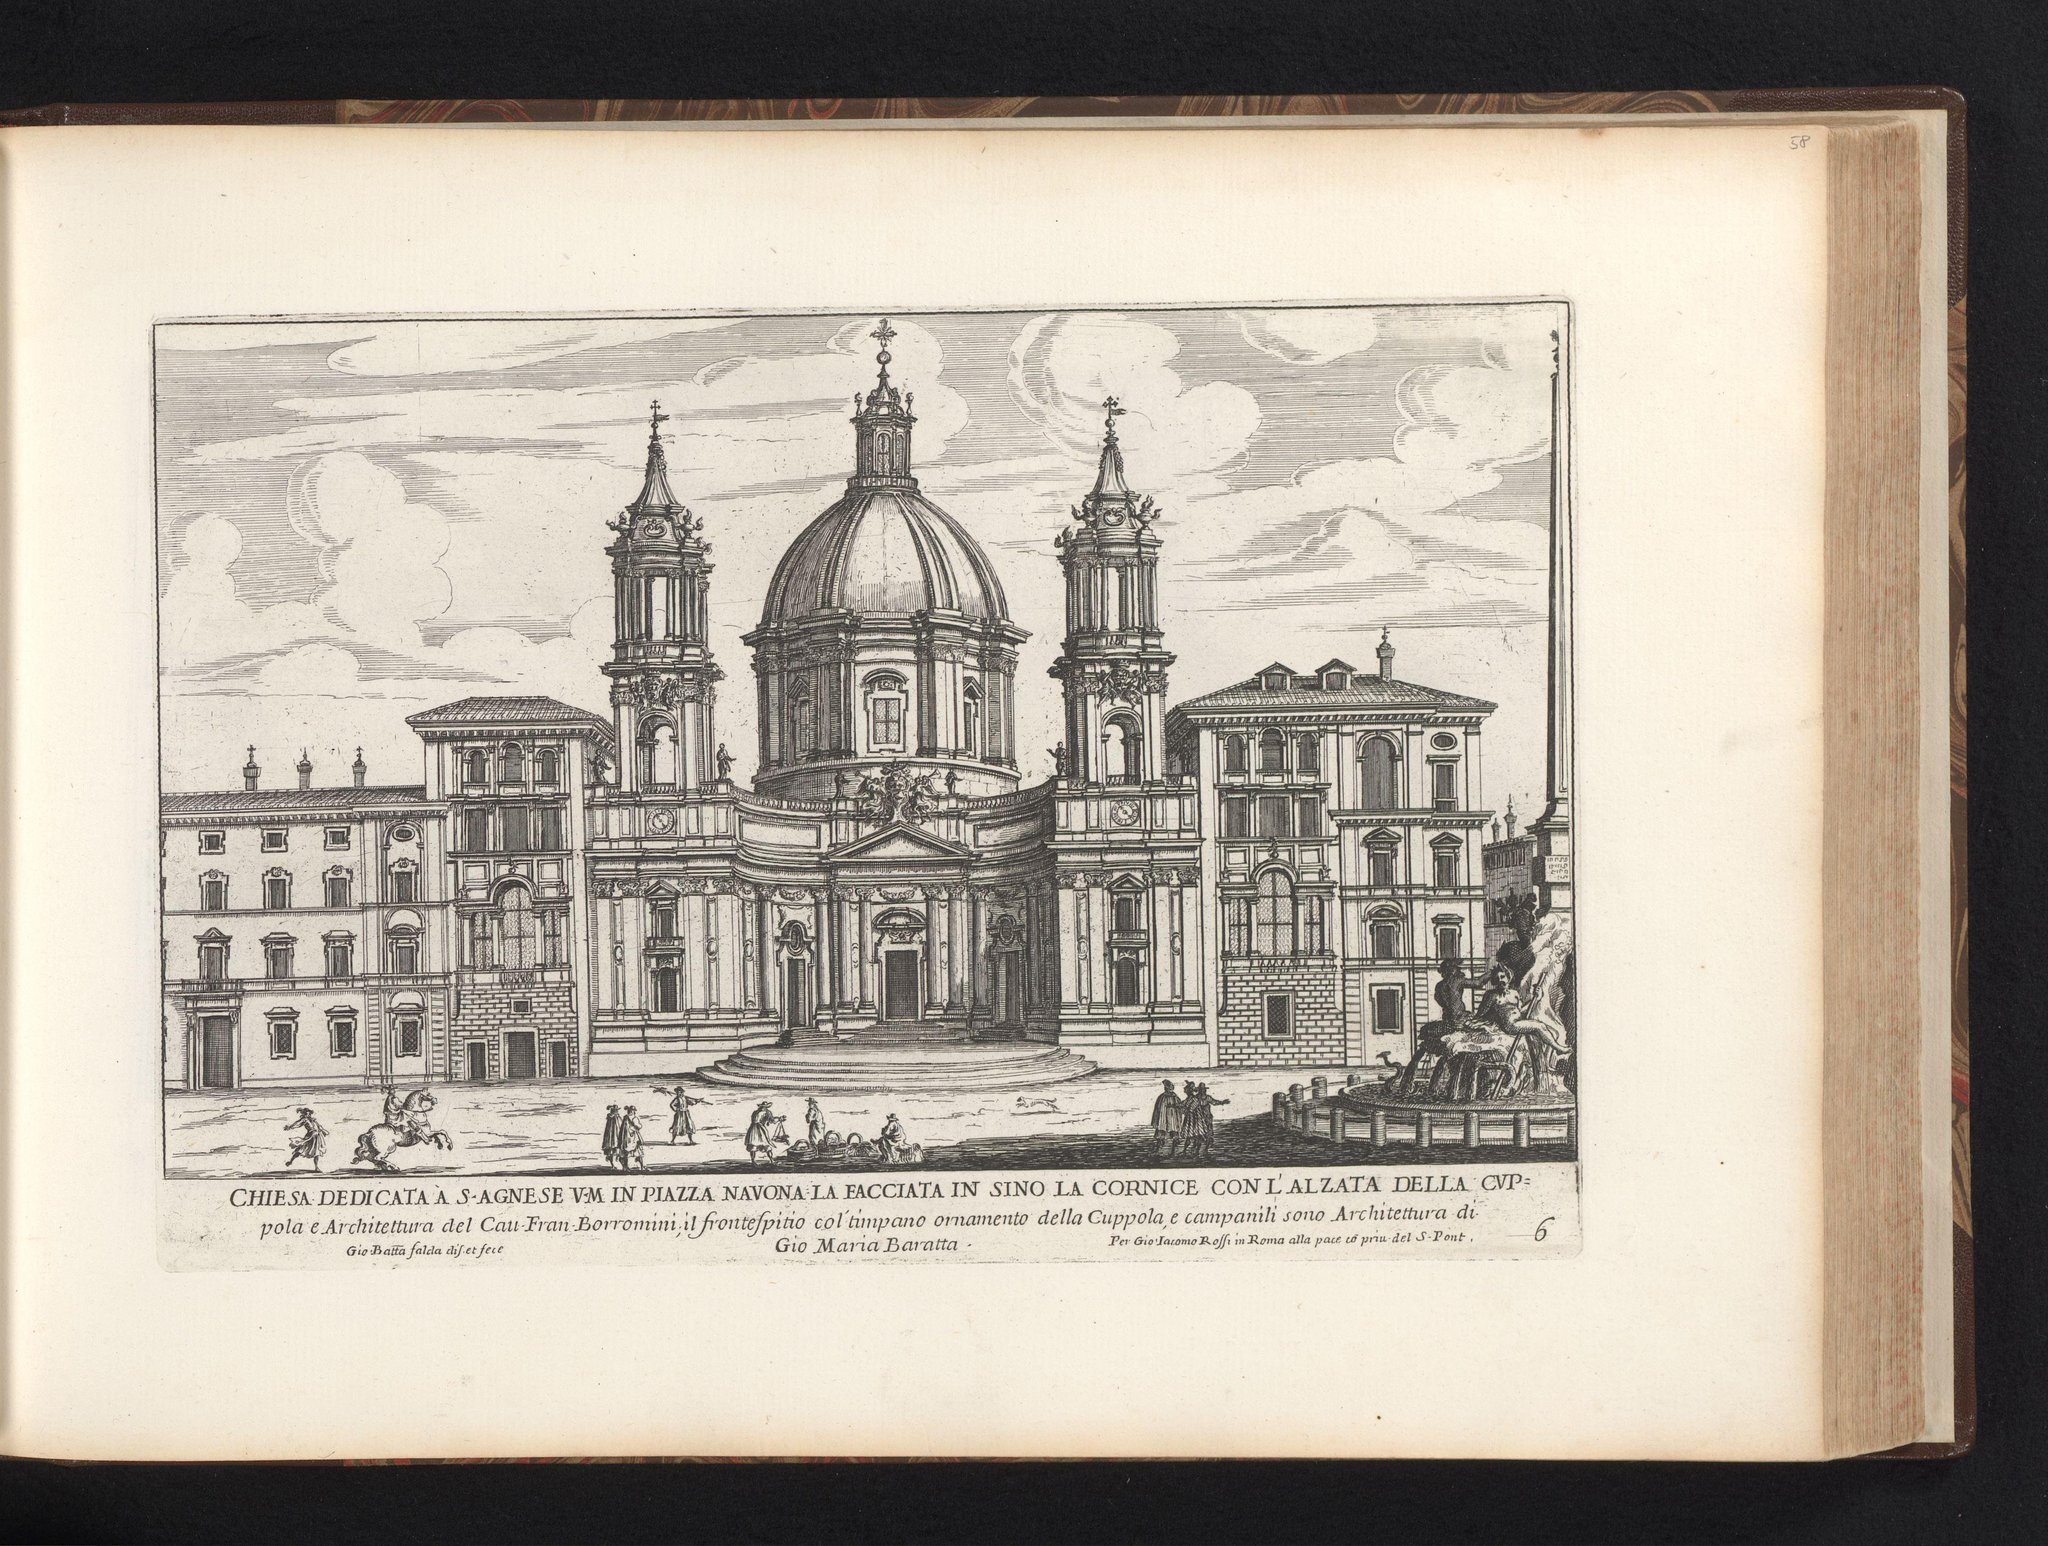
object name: album leaf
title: Il terzo libro del'novo teatro delle chiese di Roma date in luce sotto il felice pontificato di nostro signore papa Clemente IX... (libro terzo)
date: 1669-1670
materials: paper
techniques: etching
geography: italy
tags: square, place, circus, etc., city-view, and landscape with man-made constructions, church (exterior)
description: Deze titelprent maakt deel uit van een reeks van 38 prenten met voorstellingen van kerken in Rome. Samen met vier andere reeksen vormt het de grote reeks: 'Il nuovo teatro di Roma moderna'.